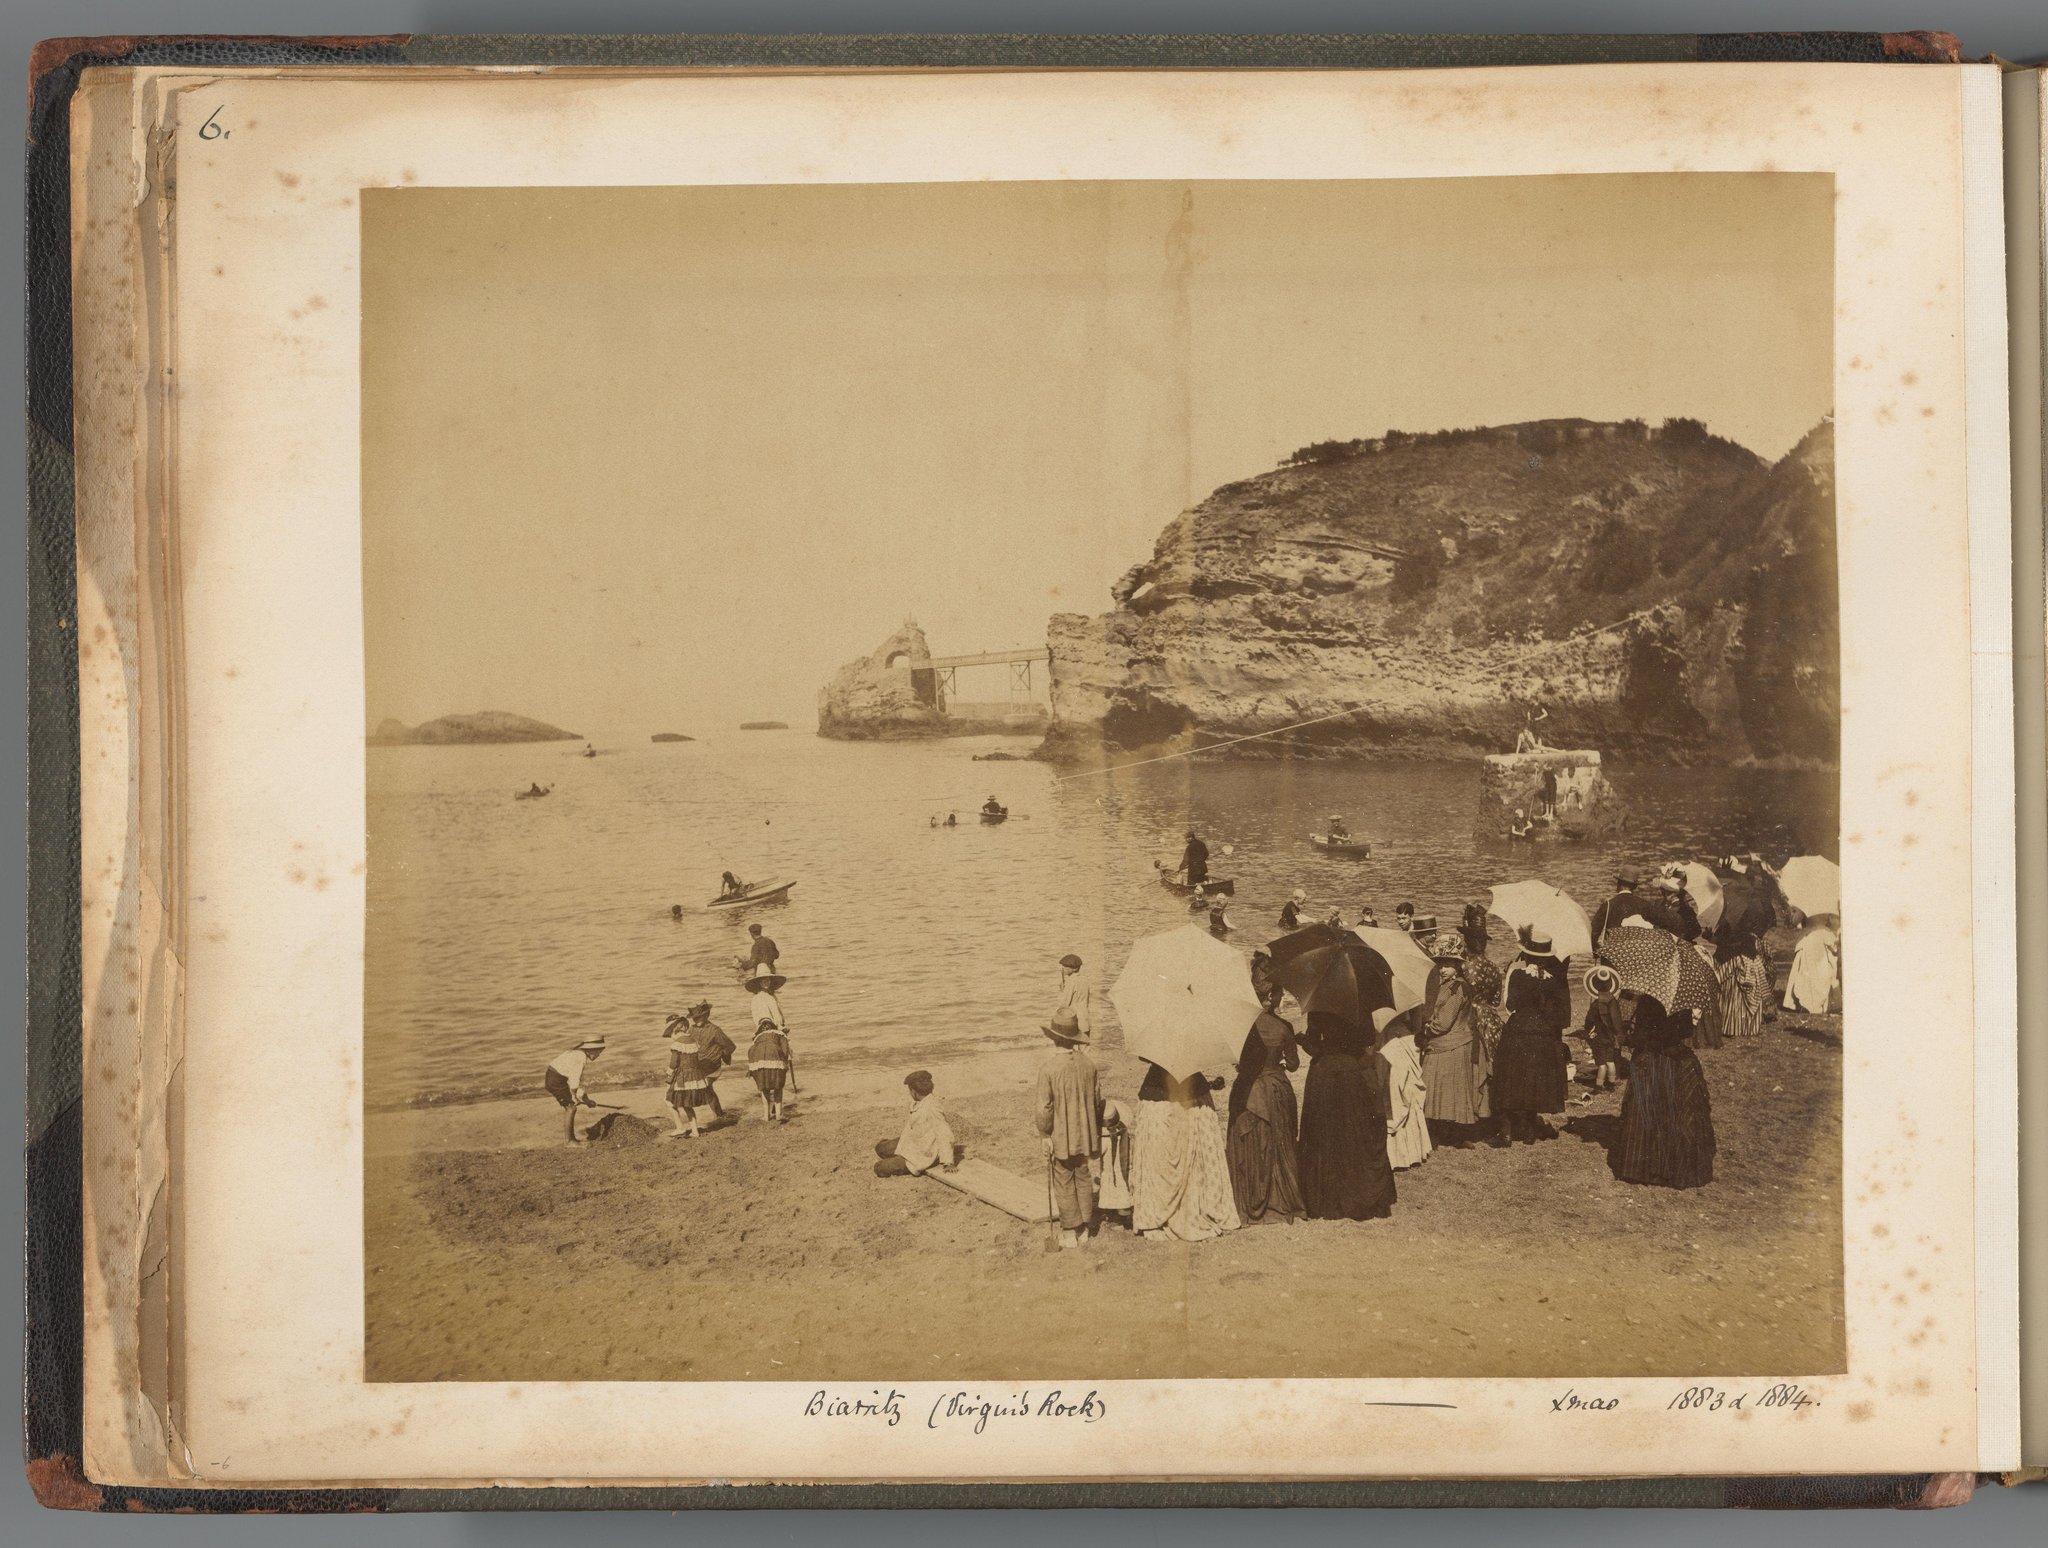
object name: photograph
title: Strand in Biarritz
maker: c.c. blackburn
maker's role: fotograaf, luitenant-kolonel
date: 1883-1884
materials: paper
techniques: albumen print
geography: biarritz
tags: beach (as place of recreation)